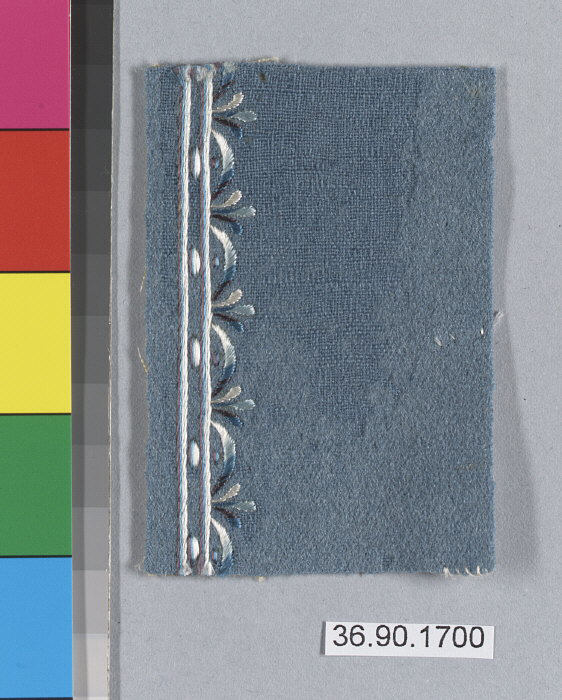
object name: sample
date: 1801-1833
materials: felt, silk